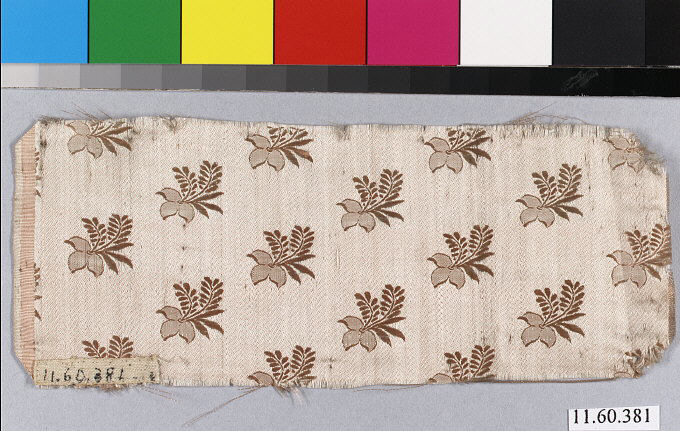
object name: fragment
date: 1801-1900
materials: silk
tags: leaves